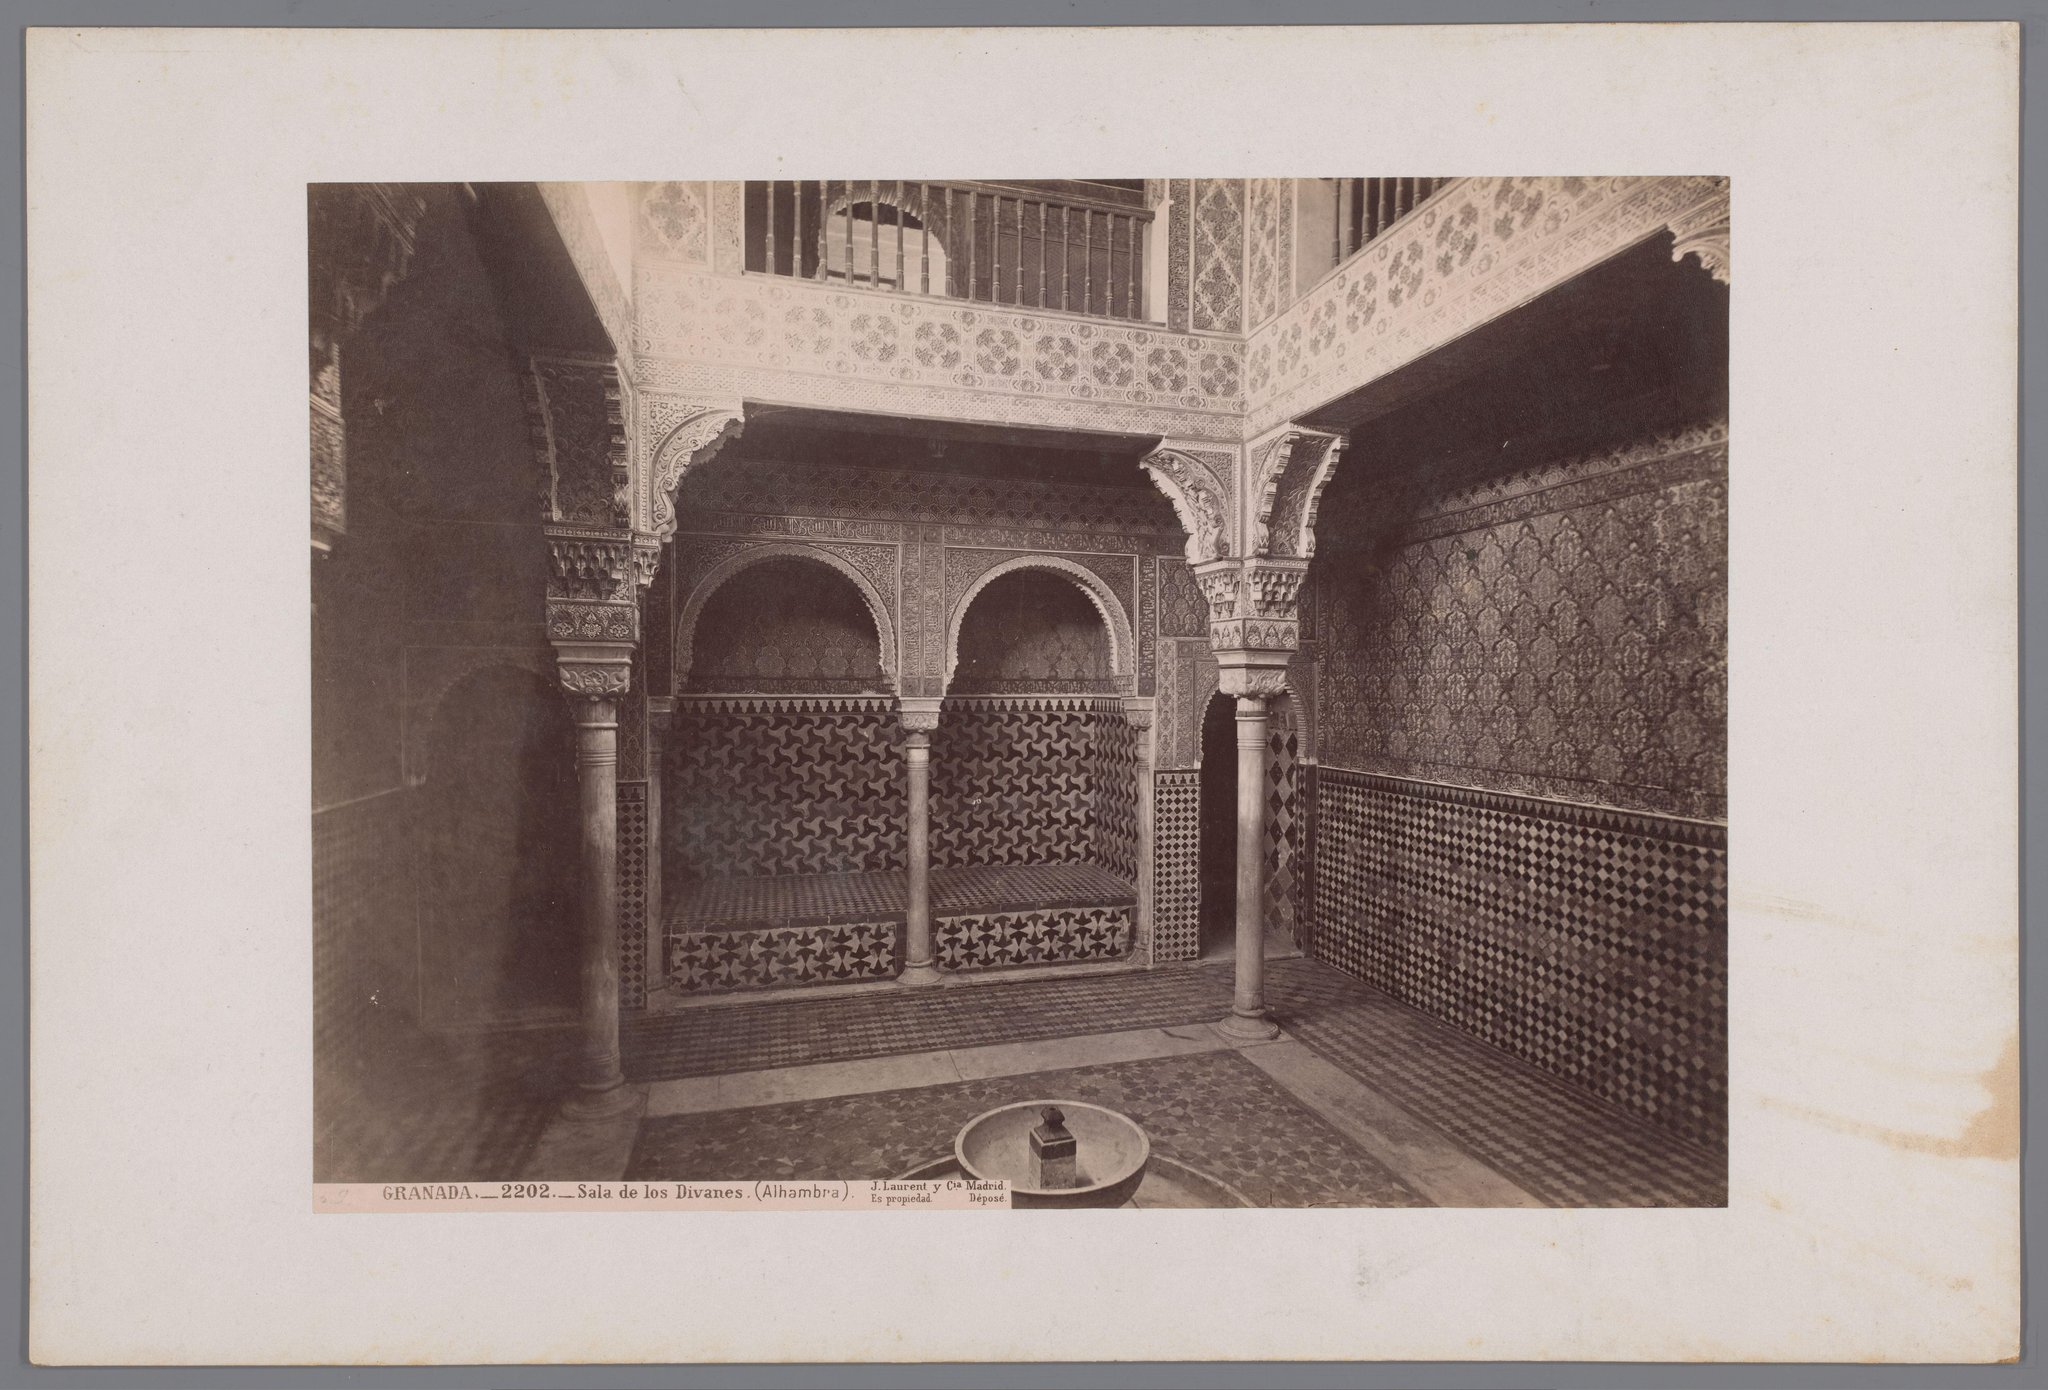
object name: photograph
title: Sala de los Divanes, Alhambra, Granada, Spanje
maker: juan laurent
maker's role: publisher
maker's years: 1816-1896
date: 1857-1890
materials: cardboard, photographic support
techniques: albumen print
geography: madrid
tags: alhambra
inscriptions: caption: ‘GRANADA._2202._ Sala de los Divanes (Alhambra).//J. Laurent y Cia Madrid//Es propiedad. Déposé.’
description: Leeg interieur met mozaïek bekleed en slanke stenen pilasters die een omgang dragen.